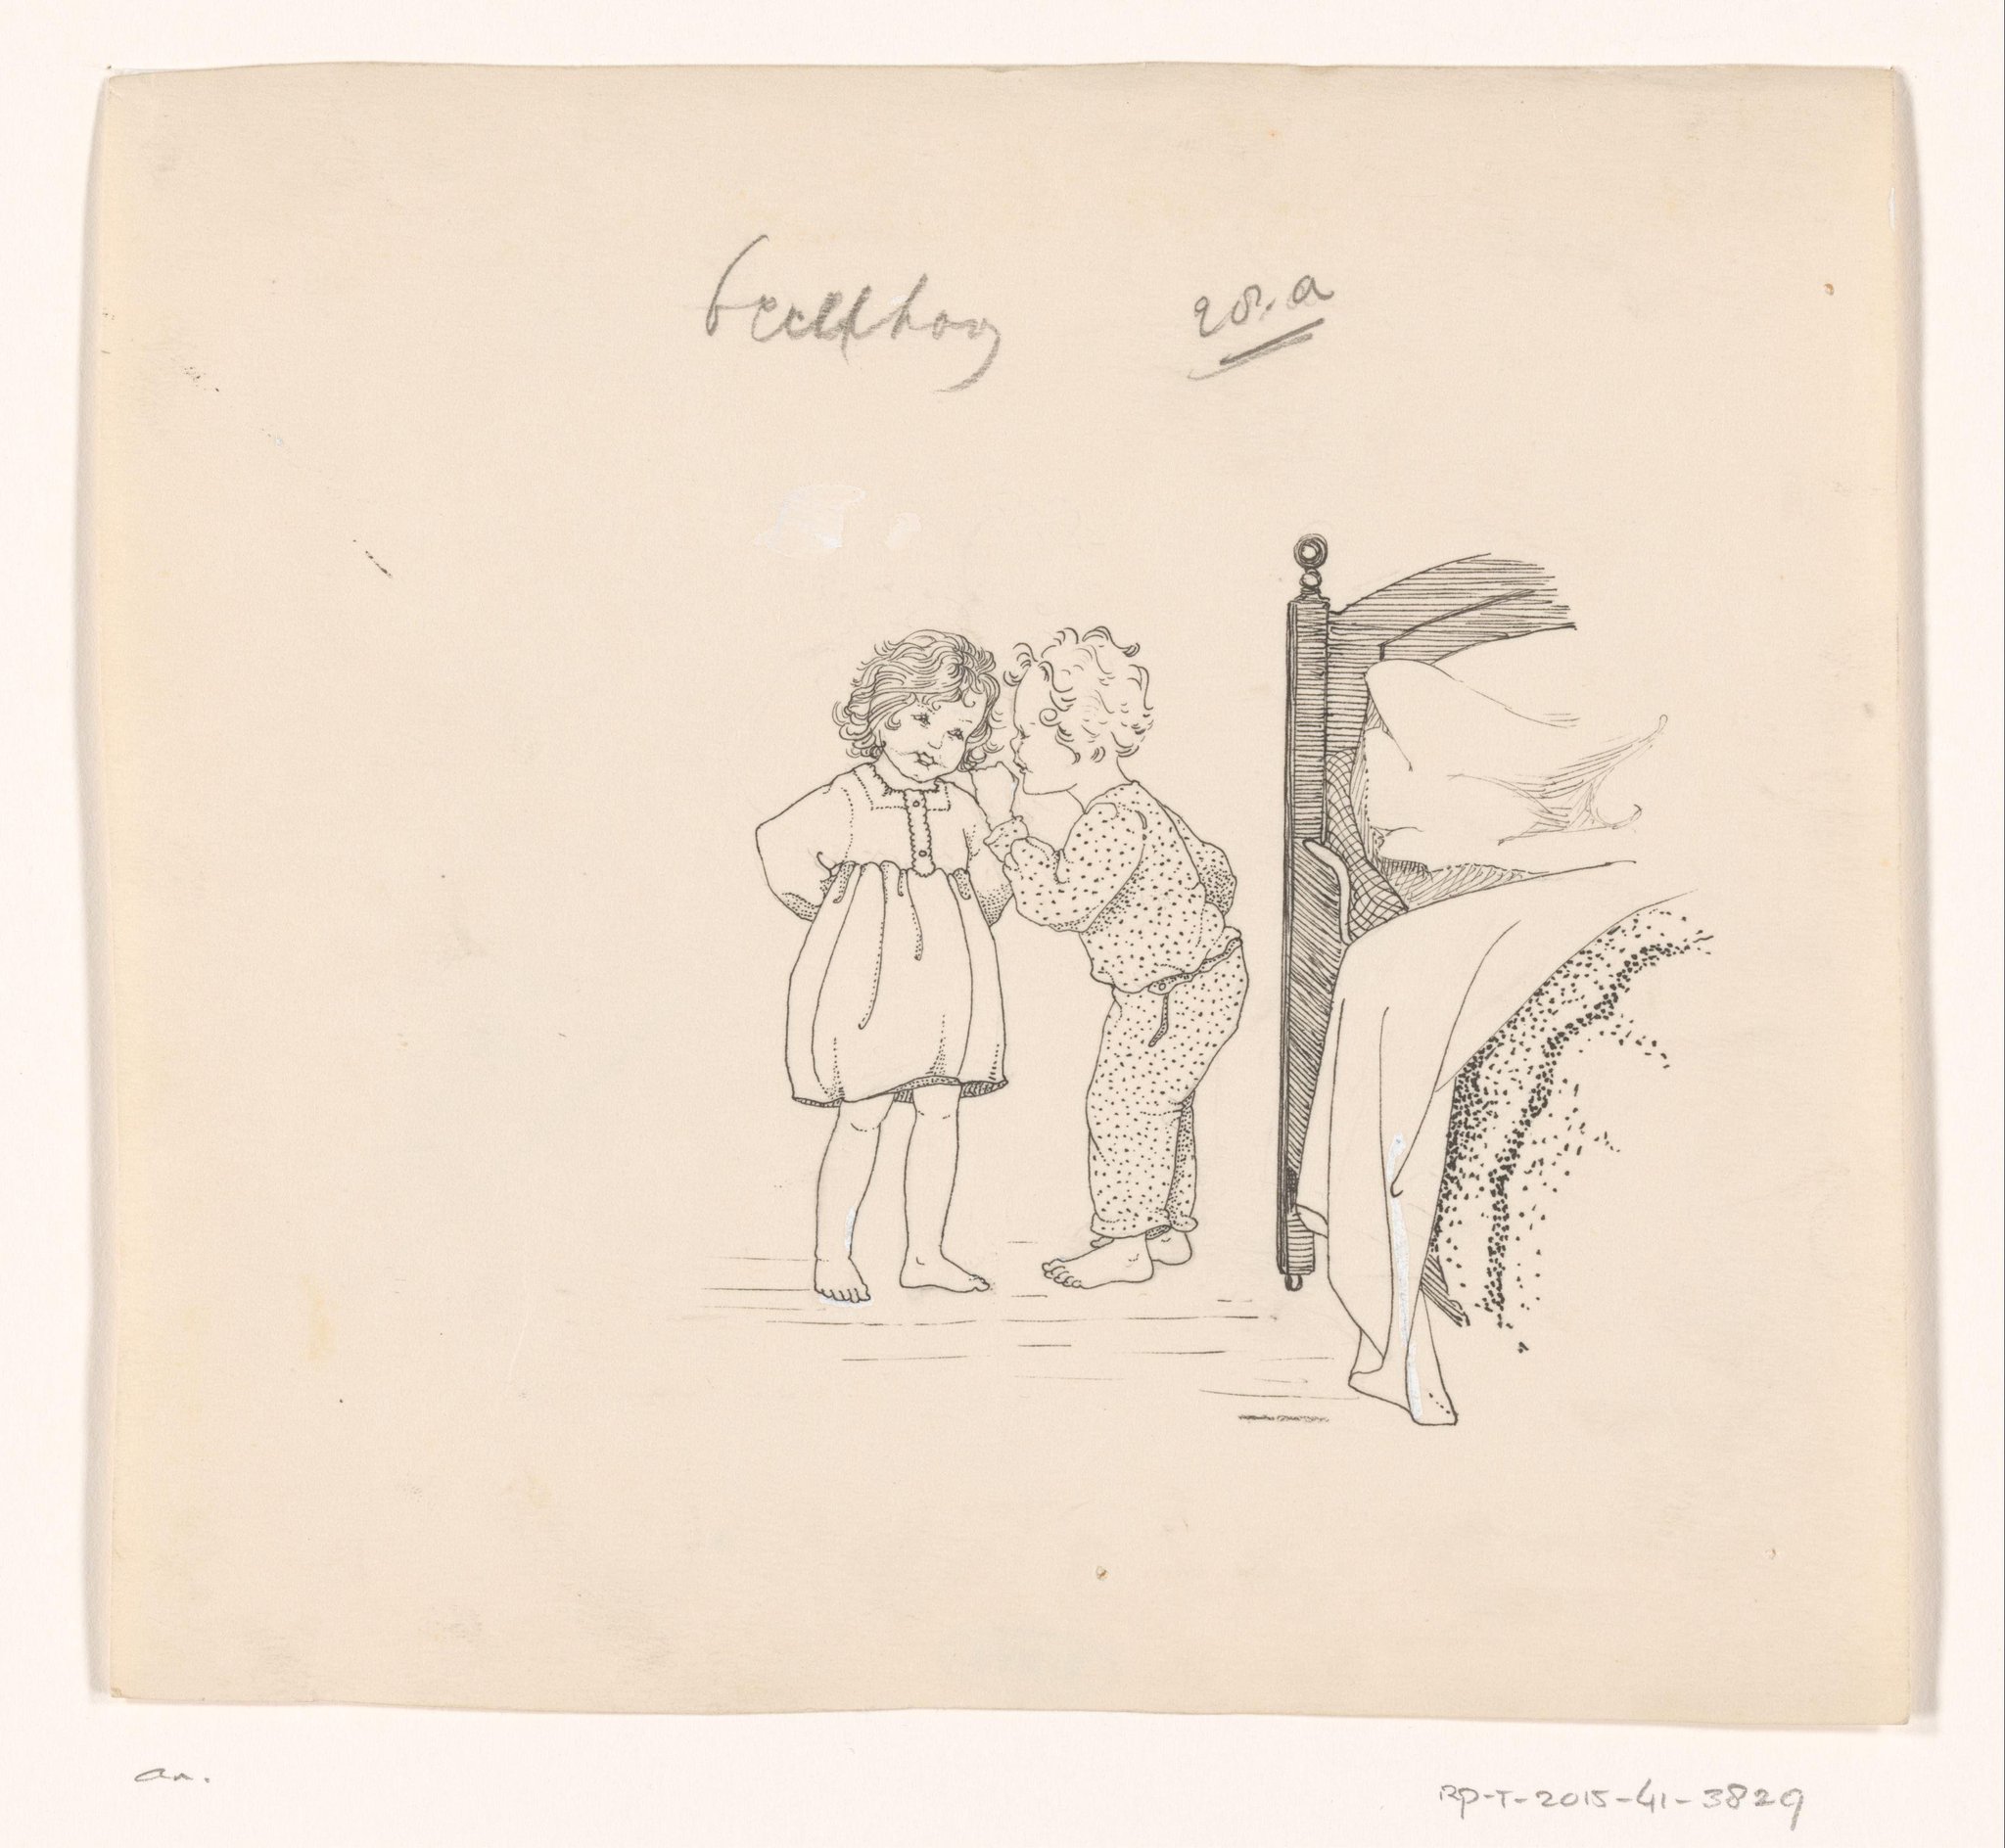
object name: drawing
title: Fluisterende meisjes naast een bed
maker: Anonymous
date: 1890-1930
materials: paint, ink, paper, pencil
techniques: brush, pen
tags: whispering, bed, nightwear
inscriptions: number: ‘28.a’, collector's mark: Lugt 2228a, :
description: Twee meisjes staan in slaapkleding naast een bed. Het ene meisje fluistert iets in het oor van het andere meisje.